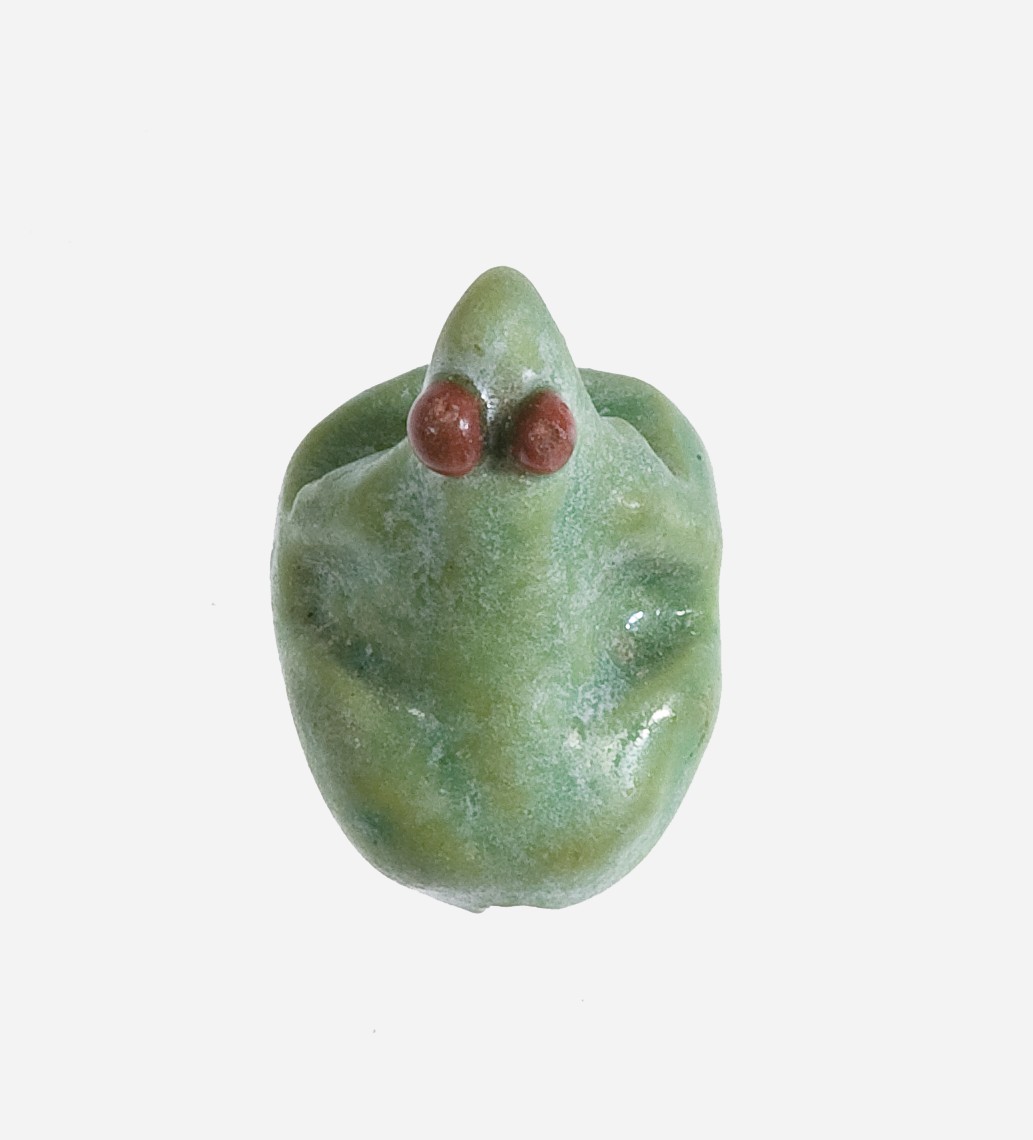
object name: stamp seal, frog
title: Frog Seal Amulet with a Maat Hieroglyph on the Base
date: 1390-1352 BCE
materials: faience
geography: egypt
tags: hieroglyphs,frogs